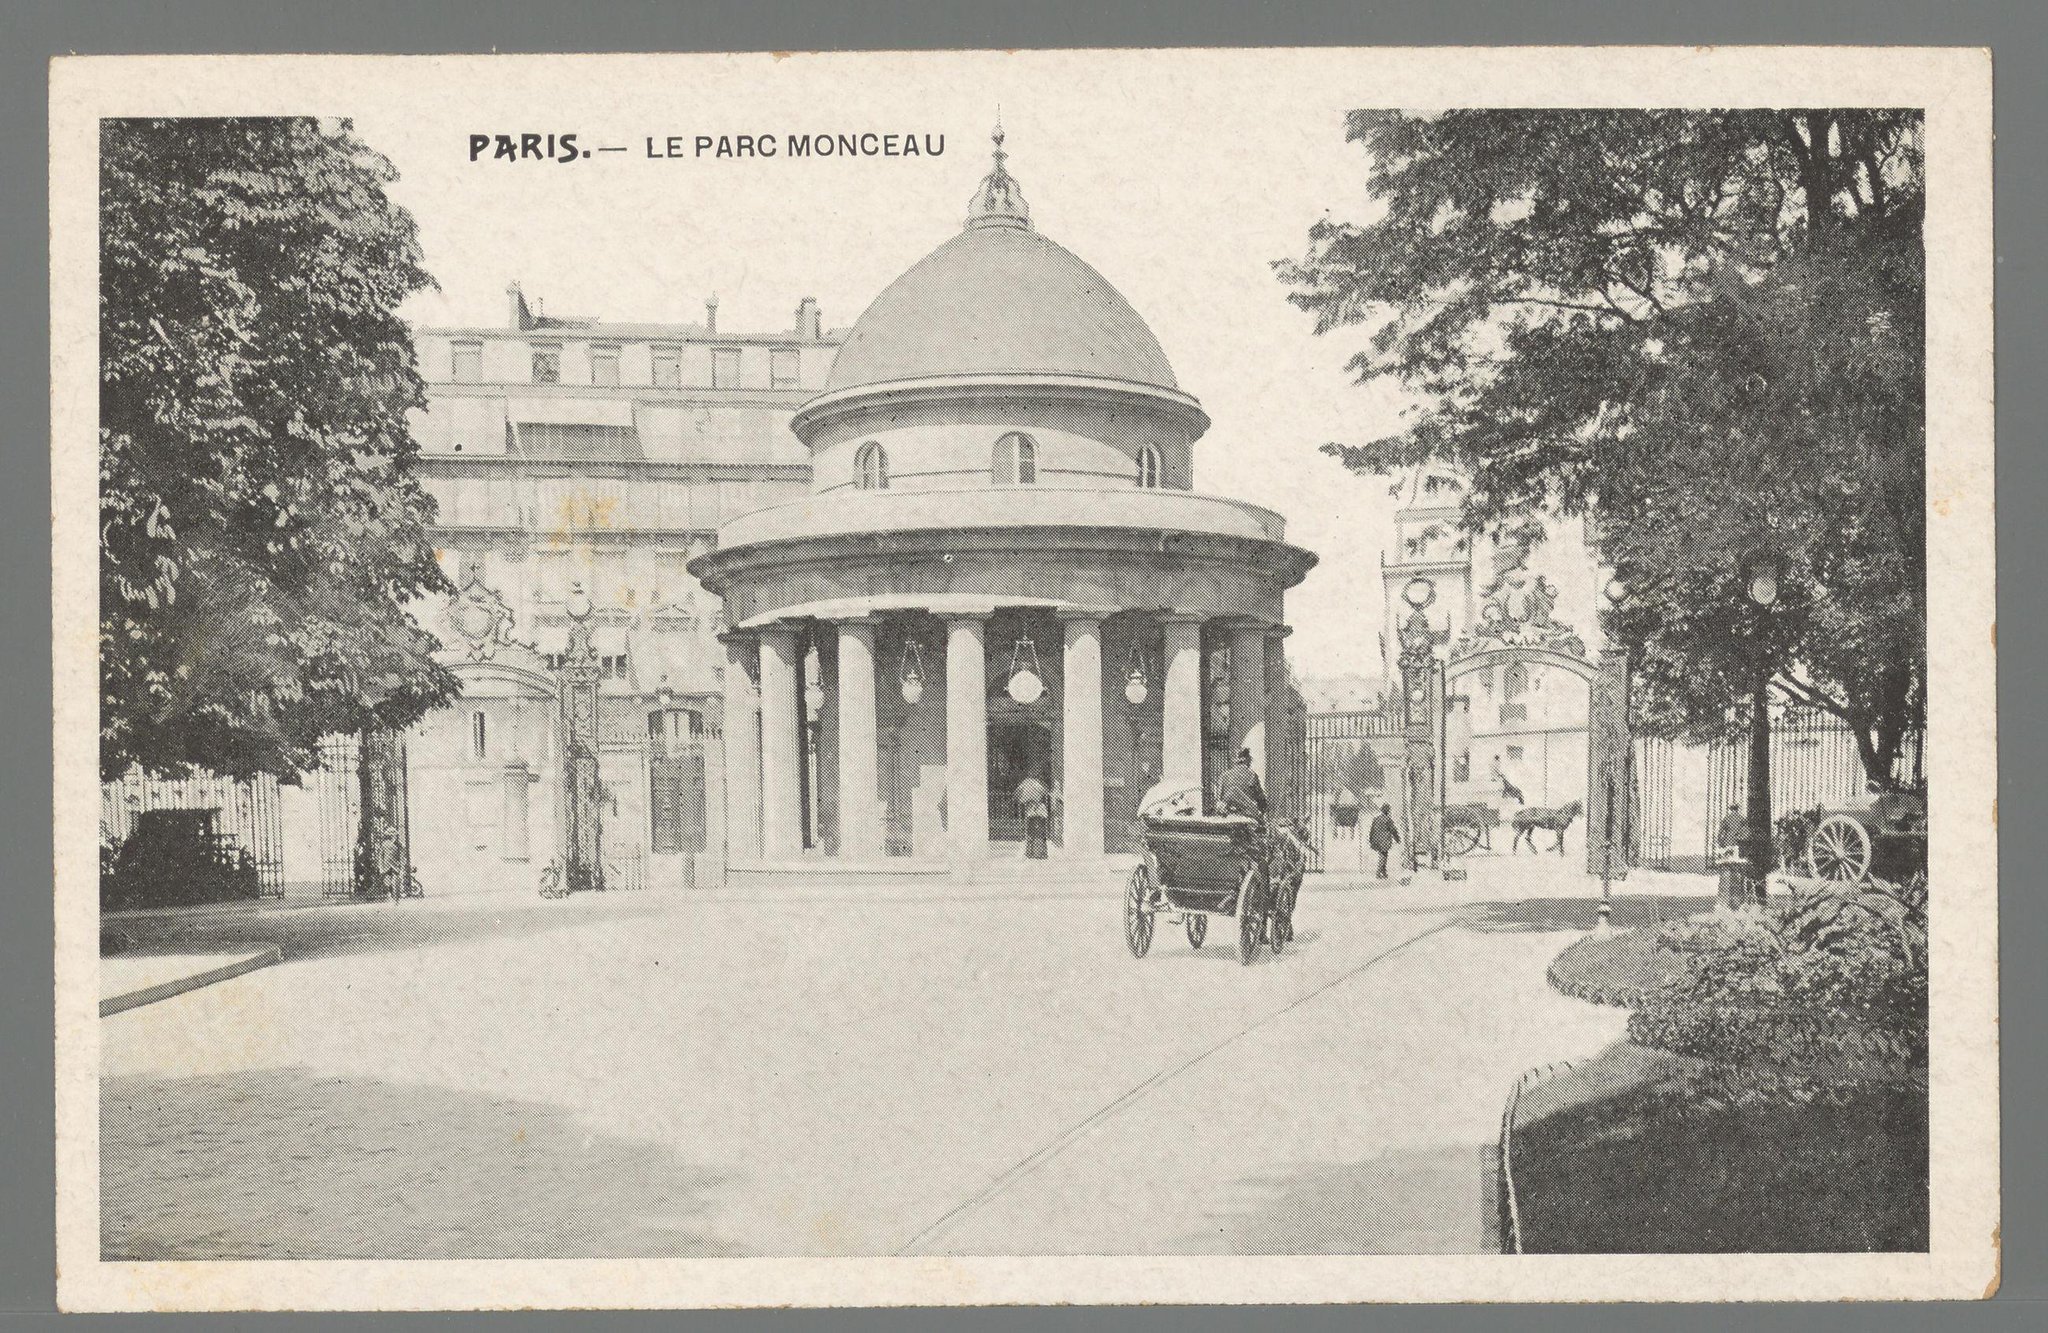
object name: ansichtkaart, prentbriefkaart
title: Paris. Le Parc Monceau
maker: Anonymous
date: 1904-1906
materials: cardboard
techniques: autotype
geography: paris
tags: four-wheeled, animal-drawn vehicle, e.g.: cab, carriage, coach, city-view, and landscape with man-made constructions (+ city(-scape) with figures, staffage)